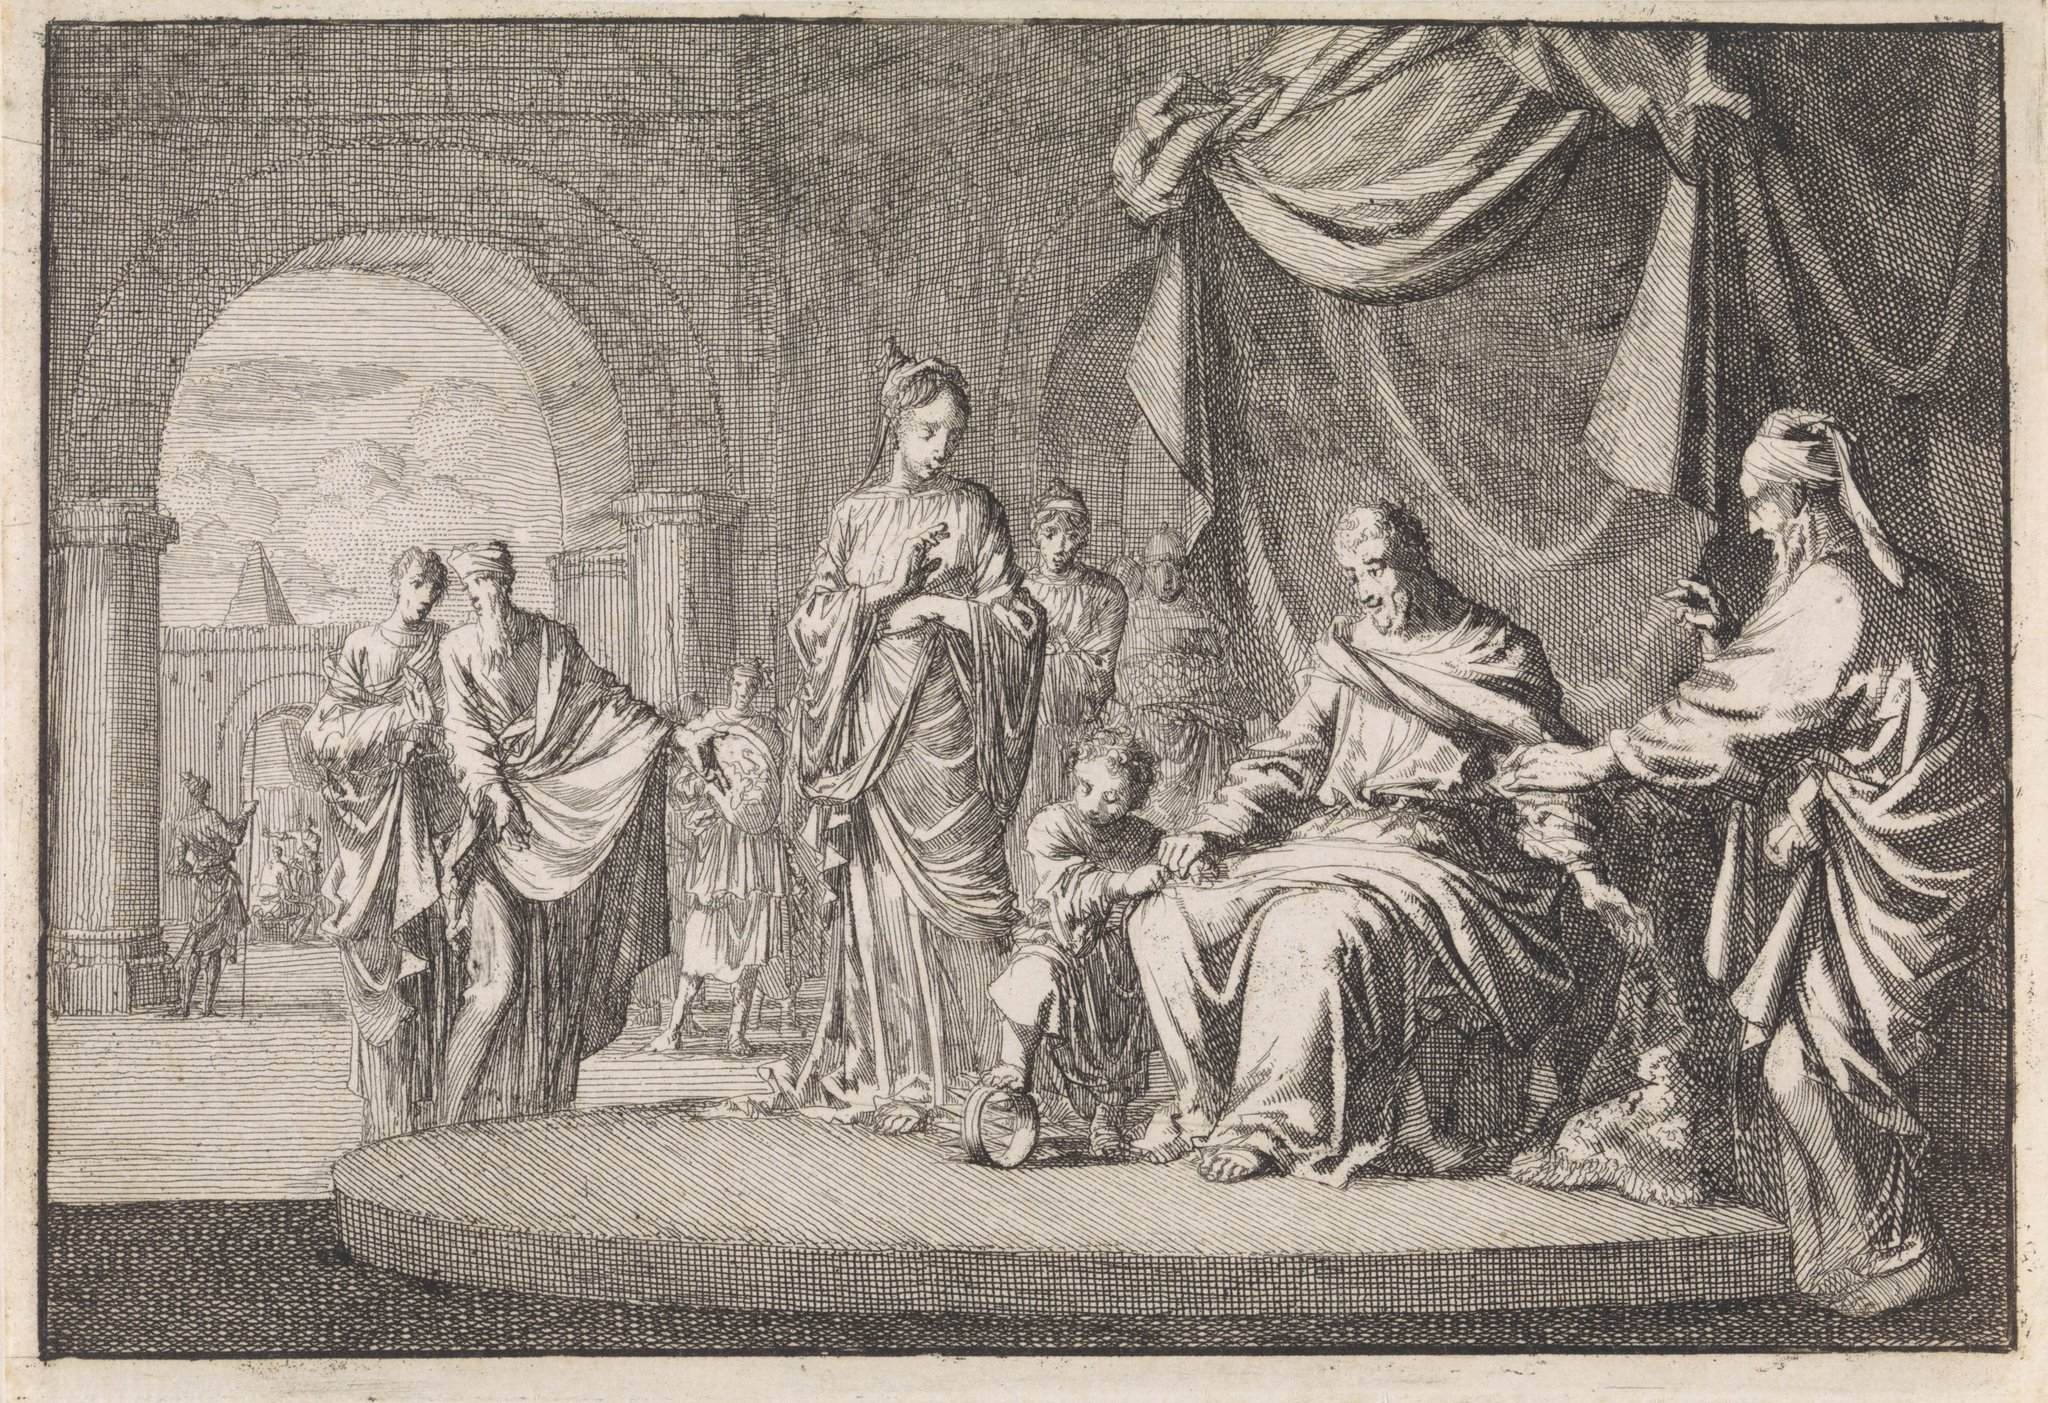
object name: print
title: Mozes en de kroon van de farao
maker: jan luyken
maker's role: draughtsman, print maker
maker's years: 1649-1712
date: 1704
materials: paper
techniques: etching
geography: amsterdam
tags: moses and pharaoh's crown: pharaoh playfully places his crown on the head of the infant moses, who throws it to the ground and tramples on it; or moses breaks the crown while playing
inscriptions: collector's mark: Lugt 2228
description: Prent ook gebruikt als boekillustratie in: Josephus, Flavius. Alle de Werken, 2 delen. Amsterdam: Pieter Mortier, 1704, dl. 1, p. 48.